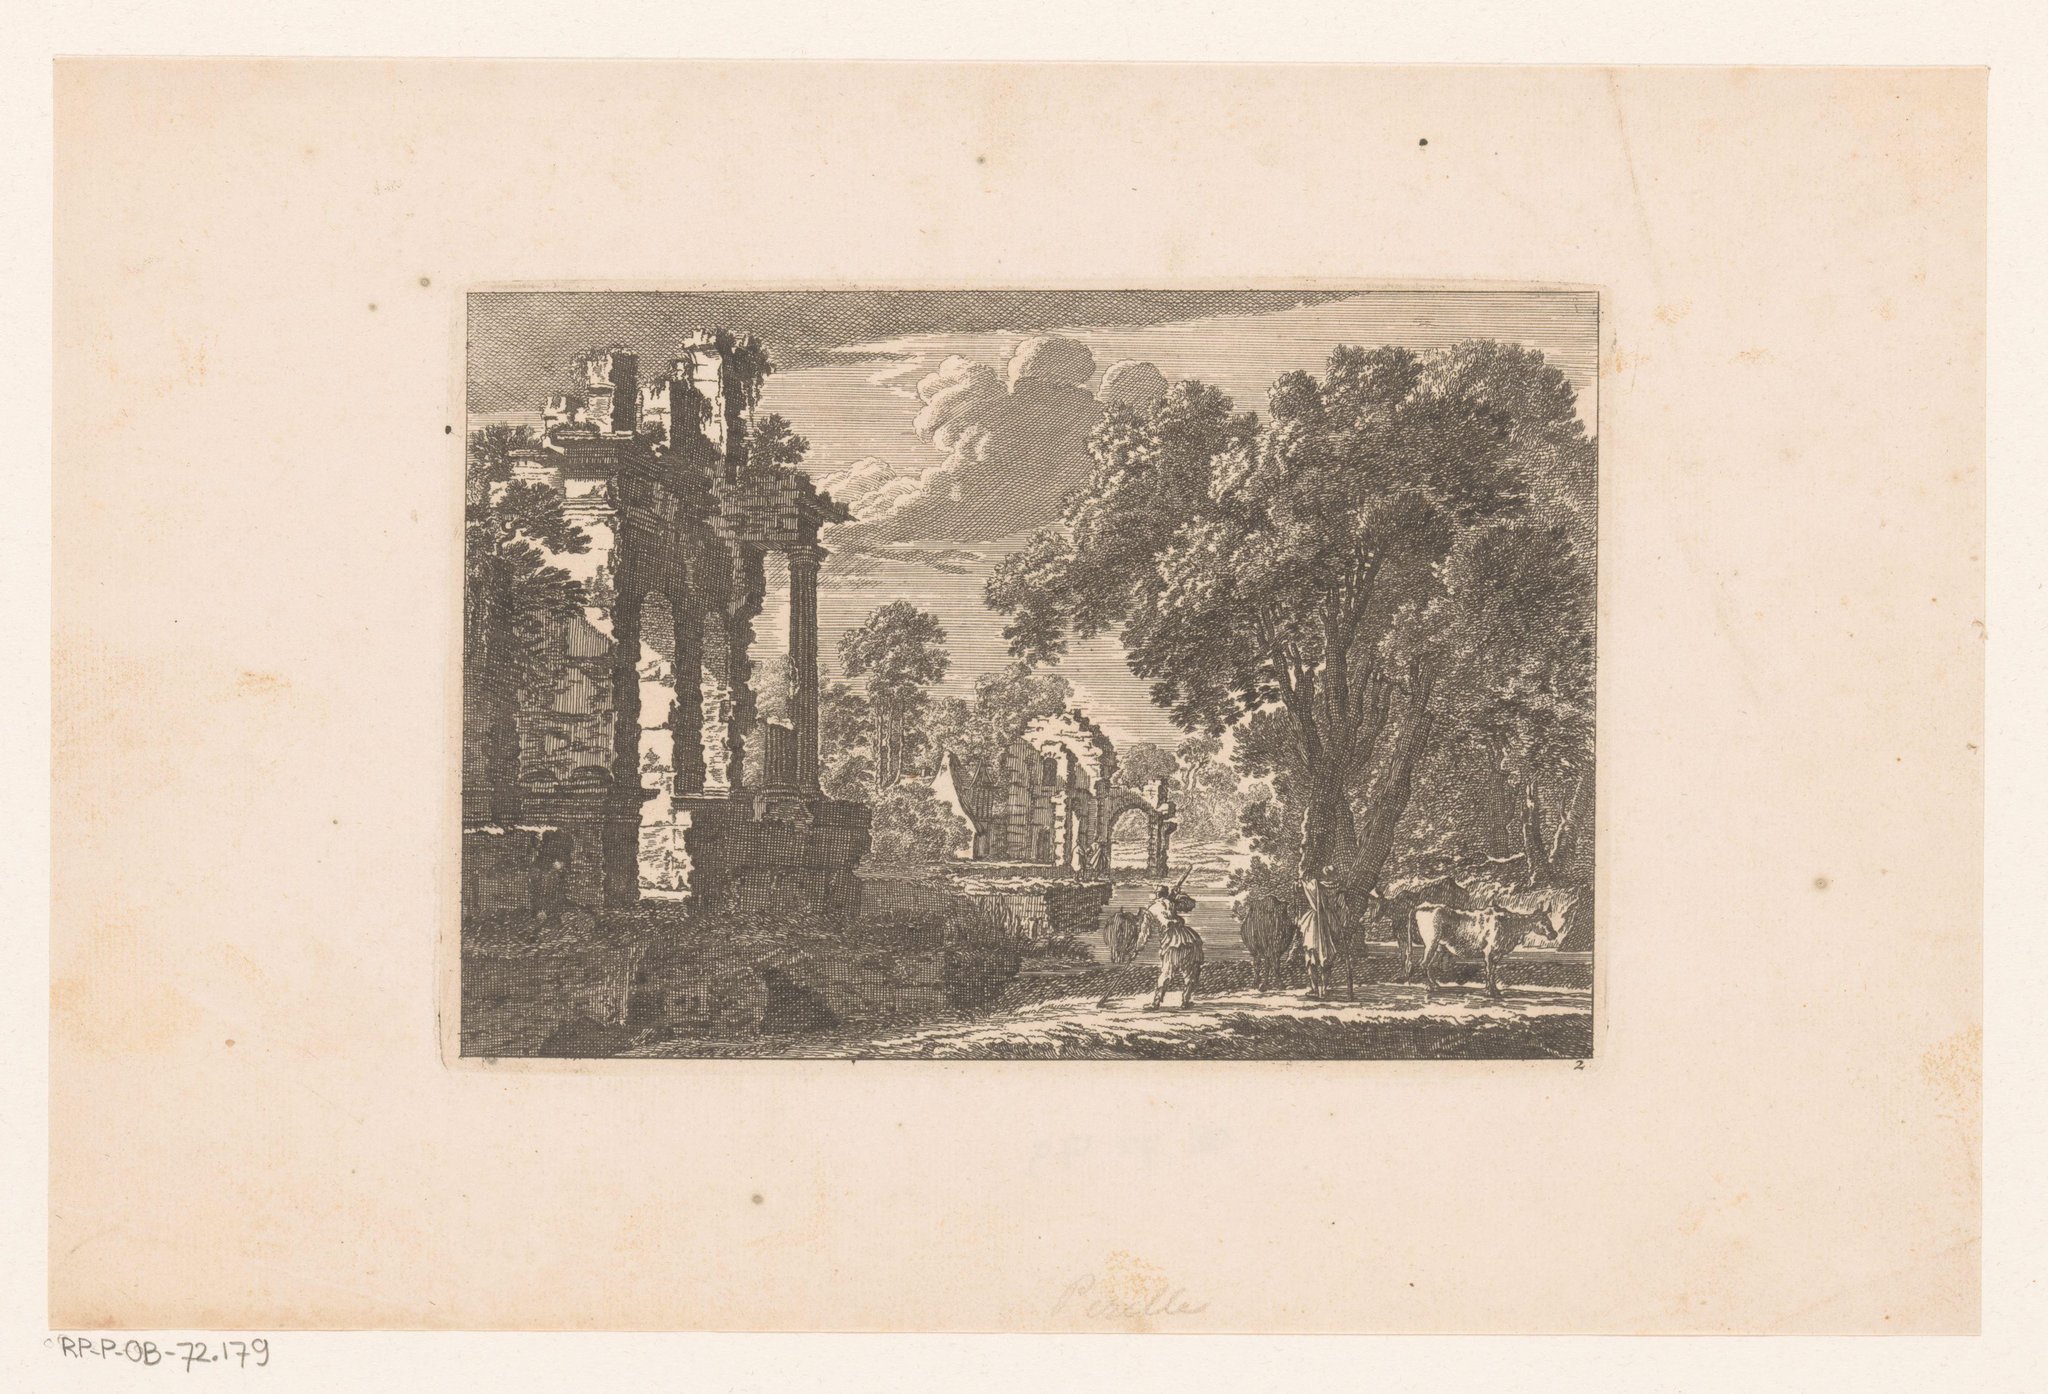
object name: print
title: Boslandschap met antieke ruïnes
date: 1613-1695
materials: paper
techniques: etching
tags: landscape with ruins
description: Prenten met het signatuur 'Perelle' kunnen zowel door vader Gabriel als door zonen Nicolas en Adam gemaakt zijn.